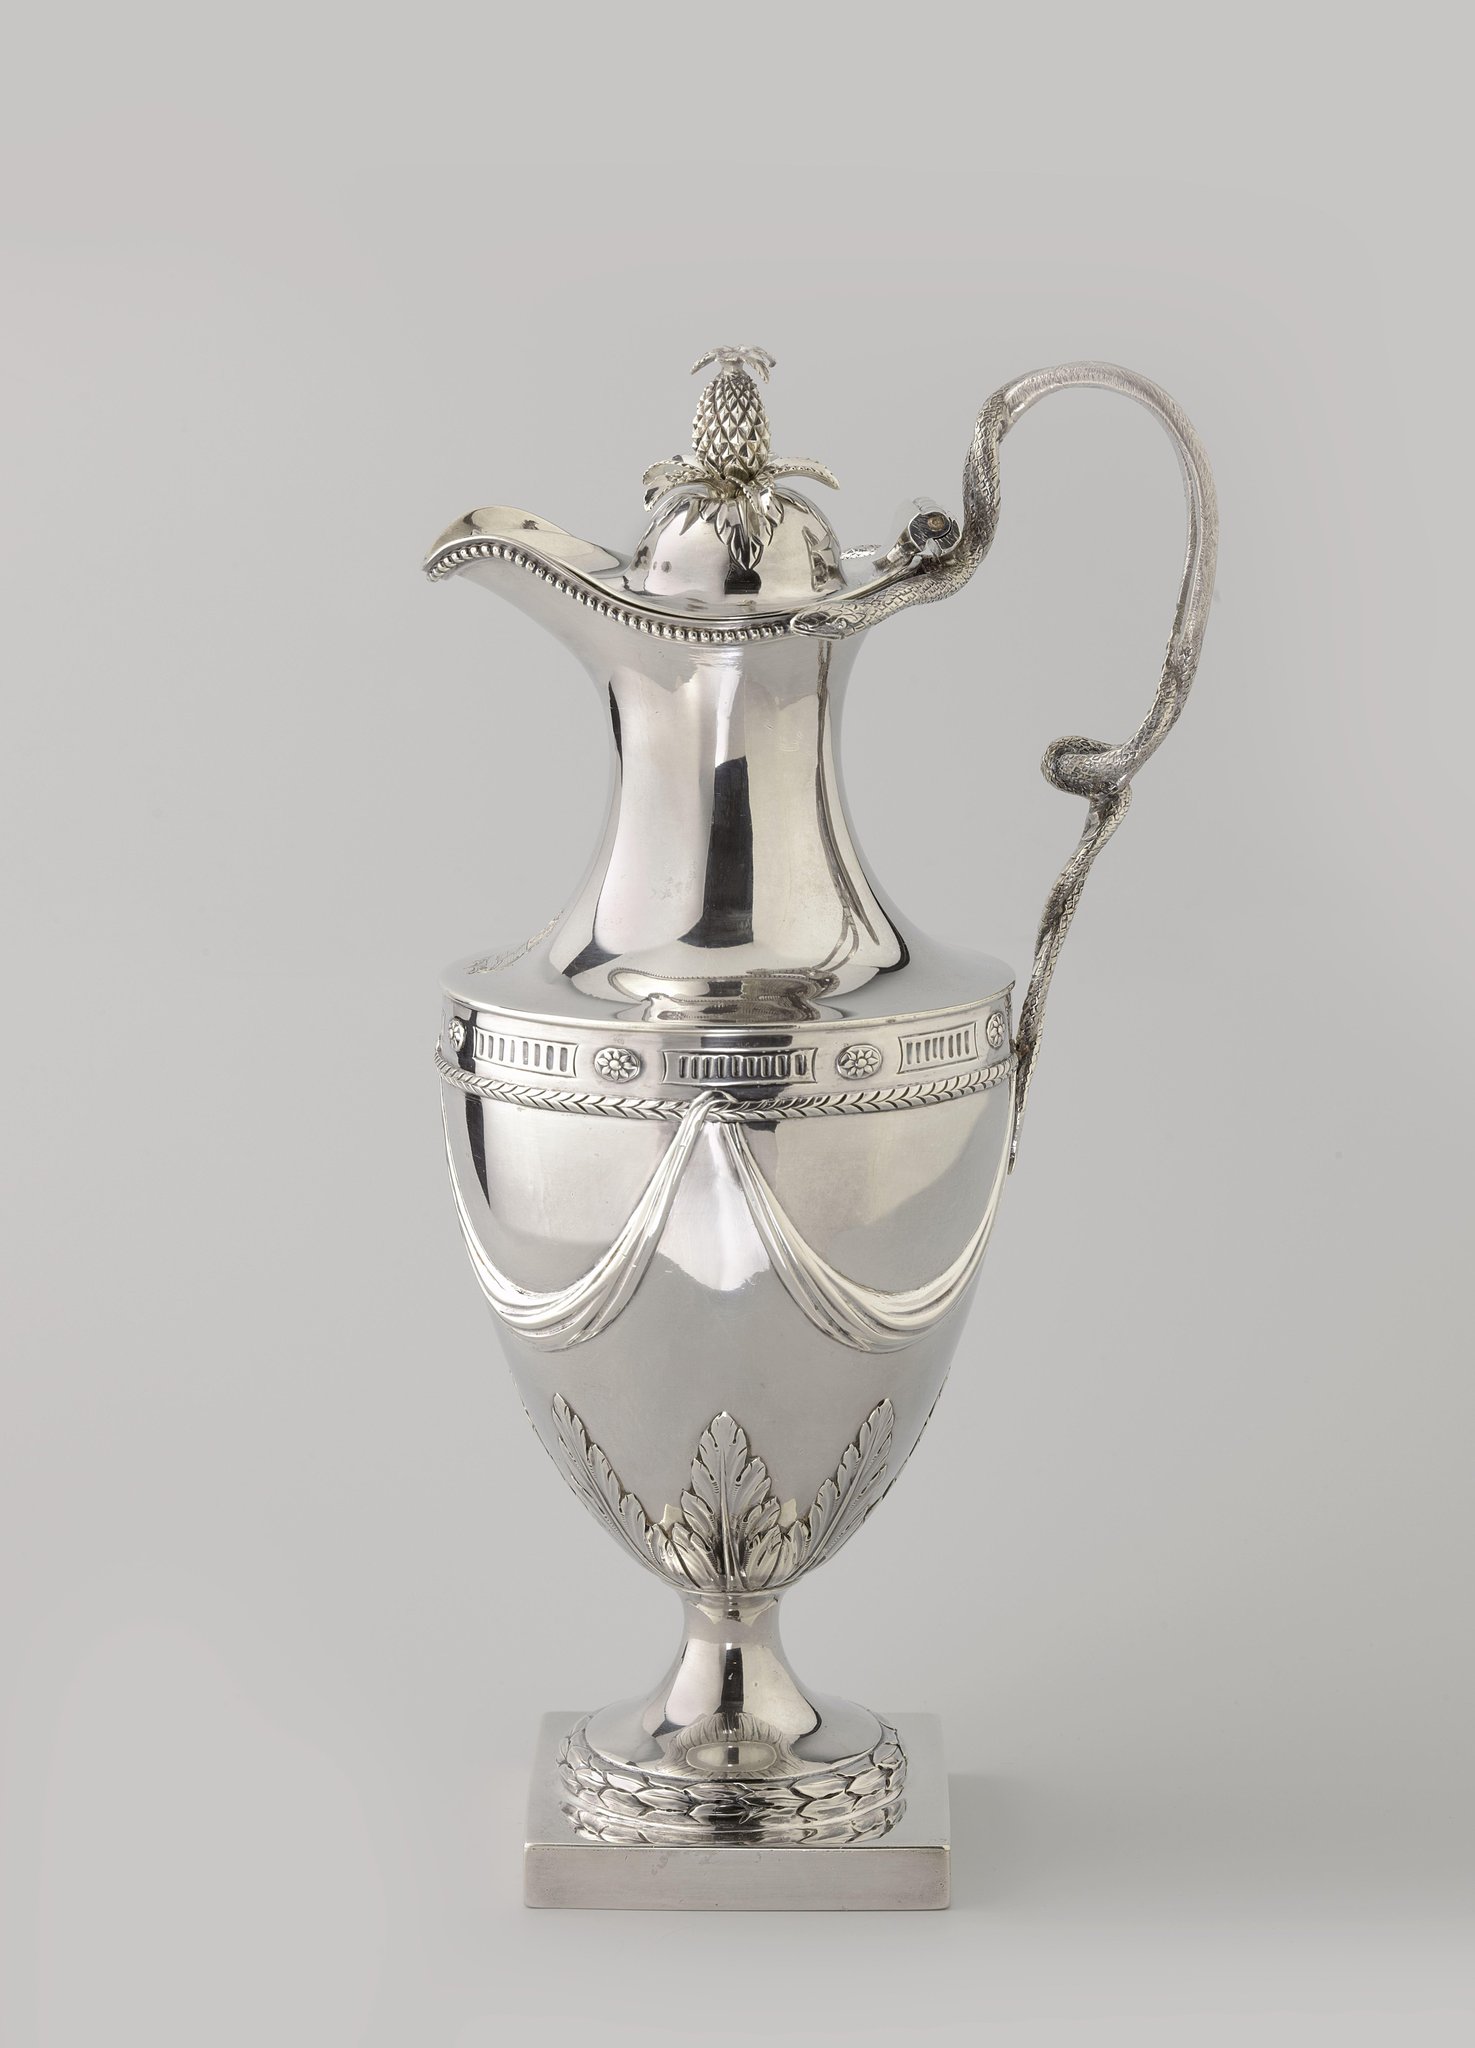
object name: ewer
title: Waterkan van zilver, vaasvormig op hoge ronde voet met vierkant basement. Hoog oor in de vorm van twee ineengekronkelde slangen. Gewelfd deksel met ananas als knop.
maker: william garrard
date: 1776-1777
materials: silver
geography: london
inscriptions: mark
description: Warmwaterkan van zilver. Het vaasvormige vat, rust op een hoge, ronde voet op en vierkante basis. Het hoge oor wordt gevormd door 2 ineengekronkelde slangen. Op het gewelfde deksel een ananas als knop.